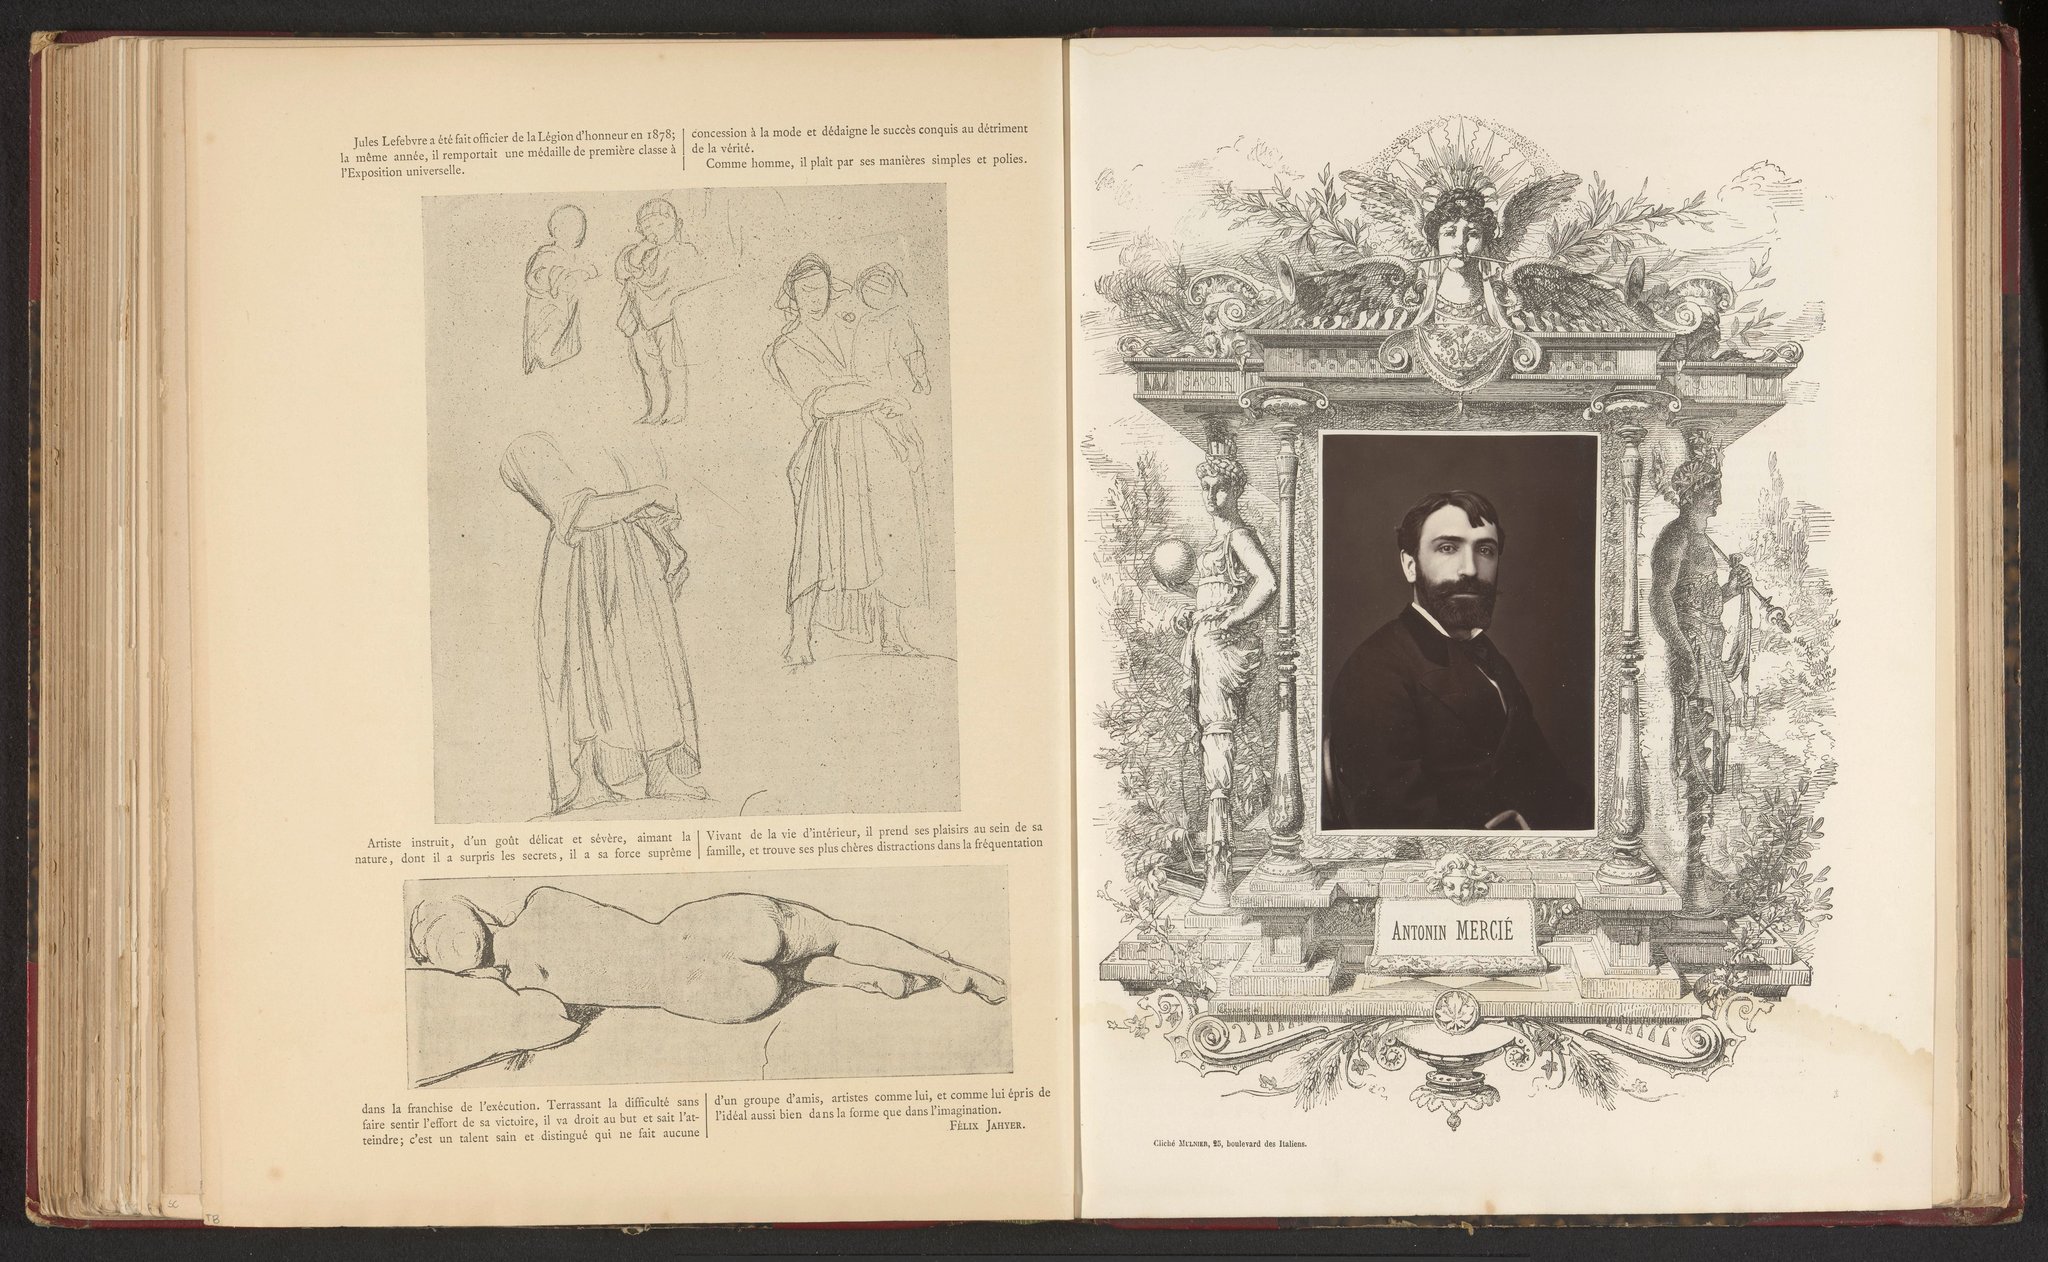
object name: photomechanical print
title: Fotoreproductie van tekeningen door vermoedelijk Jules Joseph Lefebvre, voorstellend een verzameling schetsen van een moeder met een kind op de arm en een vrouwelijk naakt op de rug gezien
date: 1876-1879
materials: paper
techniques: autotype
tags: drawing, sketch, mother and baby or young child, the (nude) human figure; 'corpo humano' (ripa) - aa - female human figure